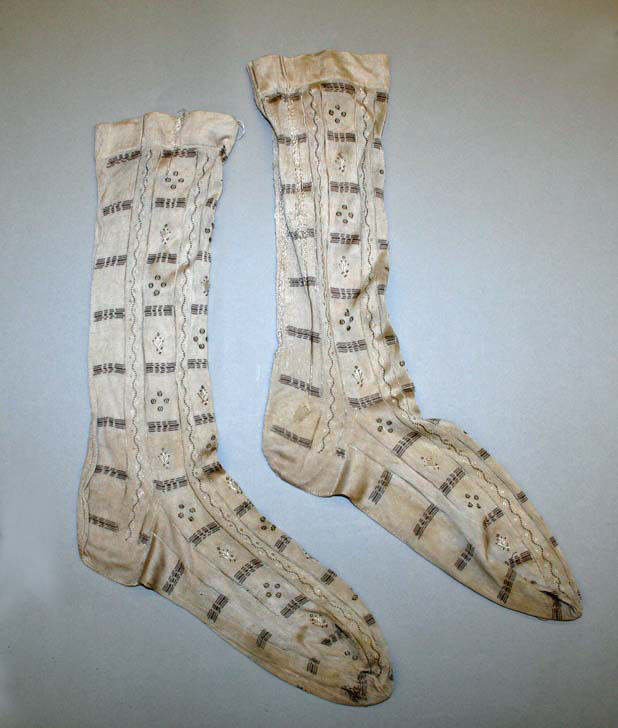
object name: sock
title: Socks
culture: european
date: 1800-1850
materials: silk